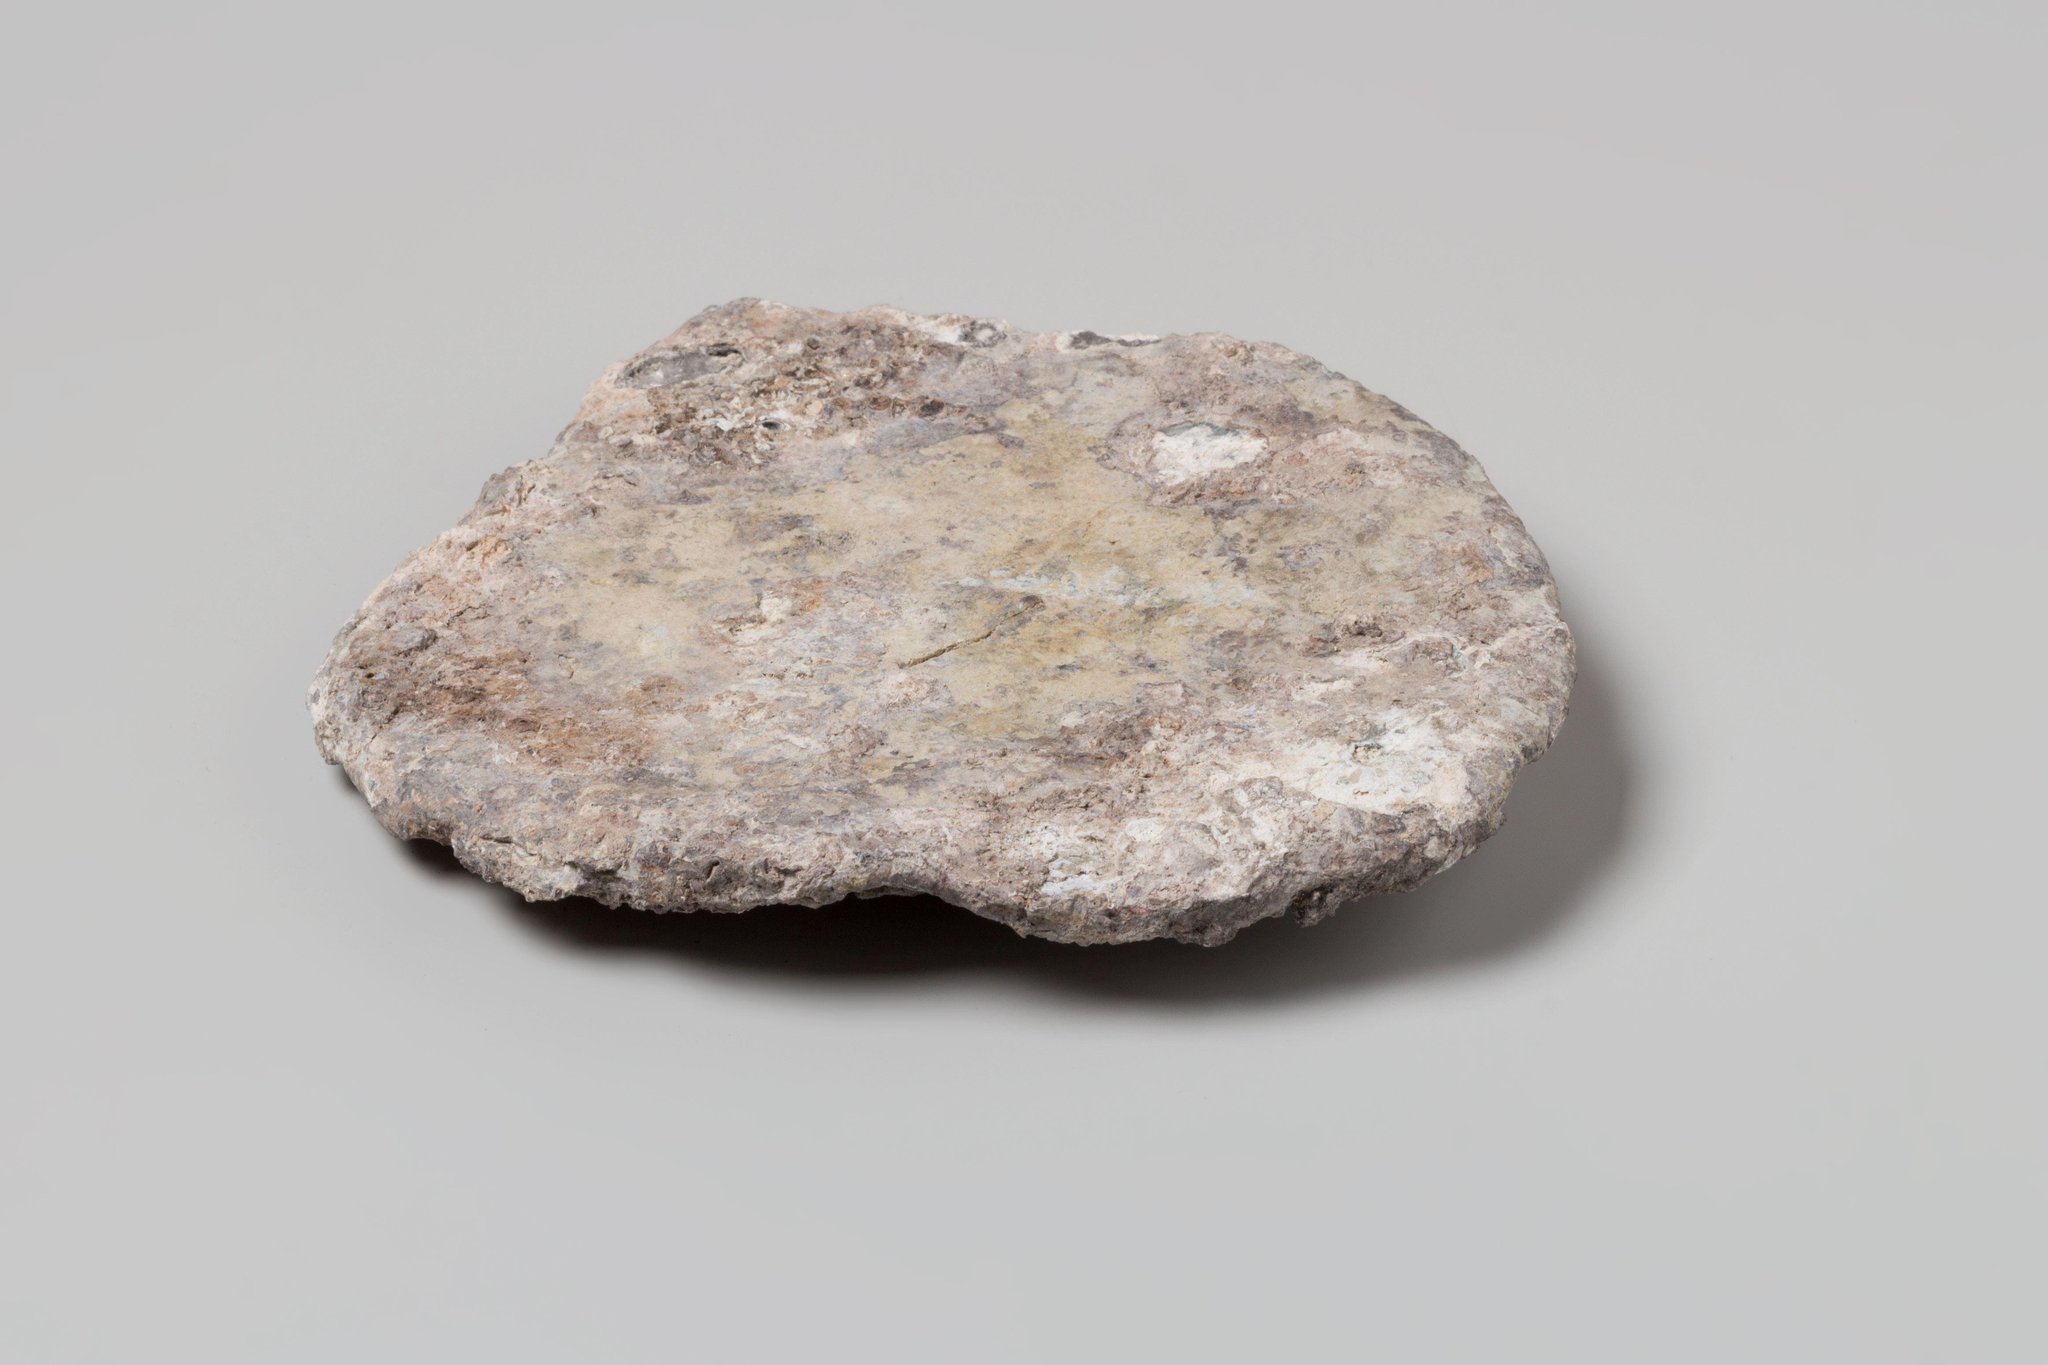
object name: concretionary stone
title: Concretie uit V.O.C.-schip de 'Witte Leeuw'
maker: Anonymous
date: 1613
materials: lead, pigment, tin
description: Bijna cirkelvormig stuk concretie met loden of tinnen kern.